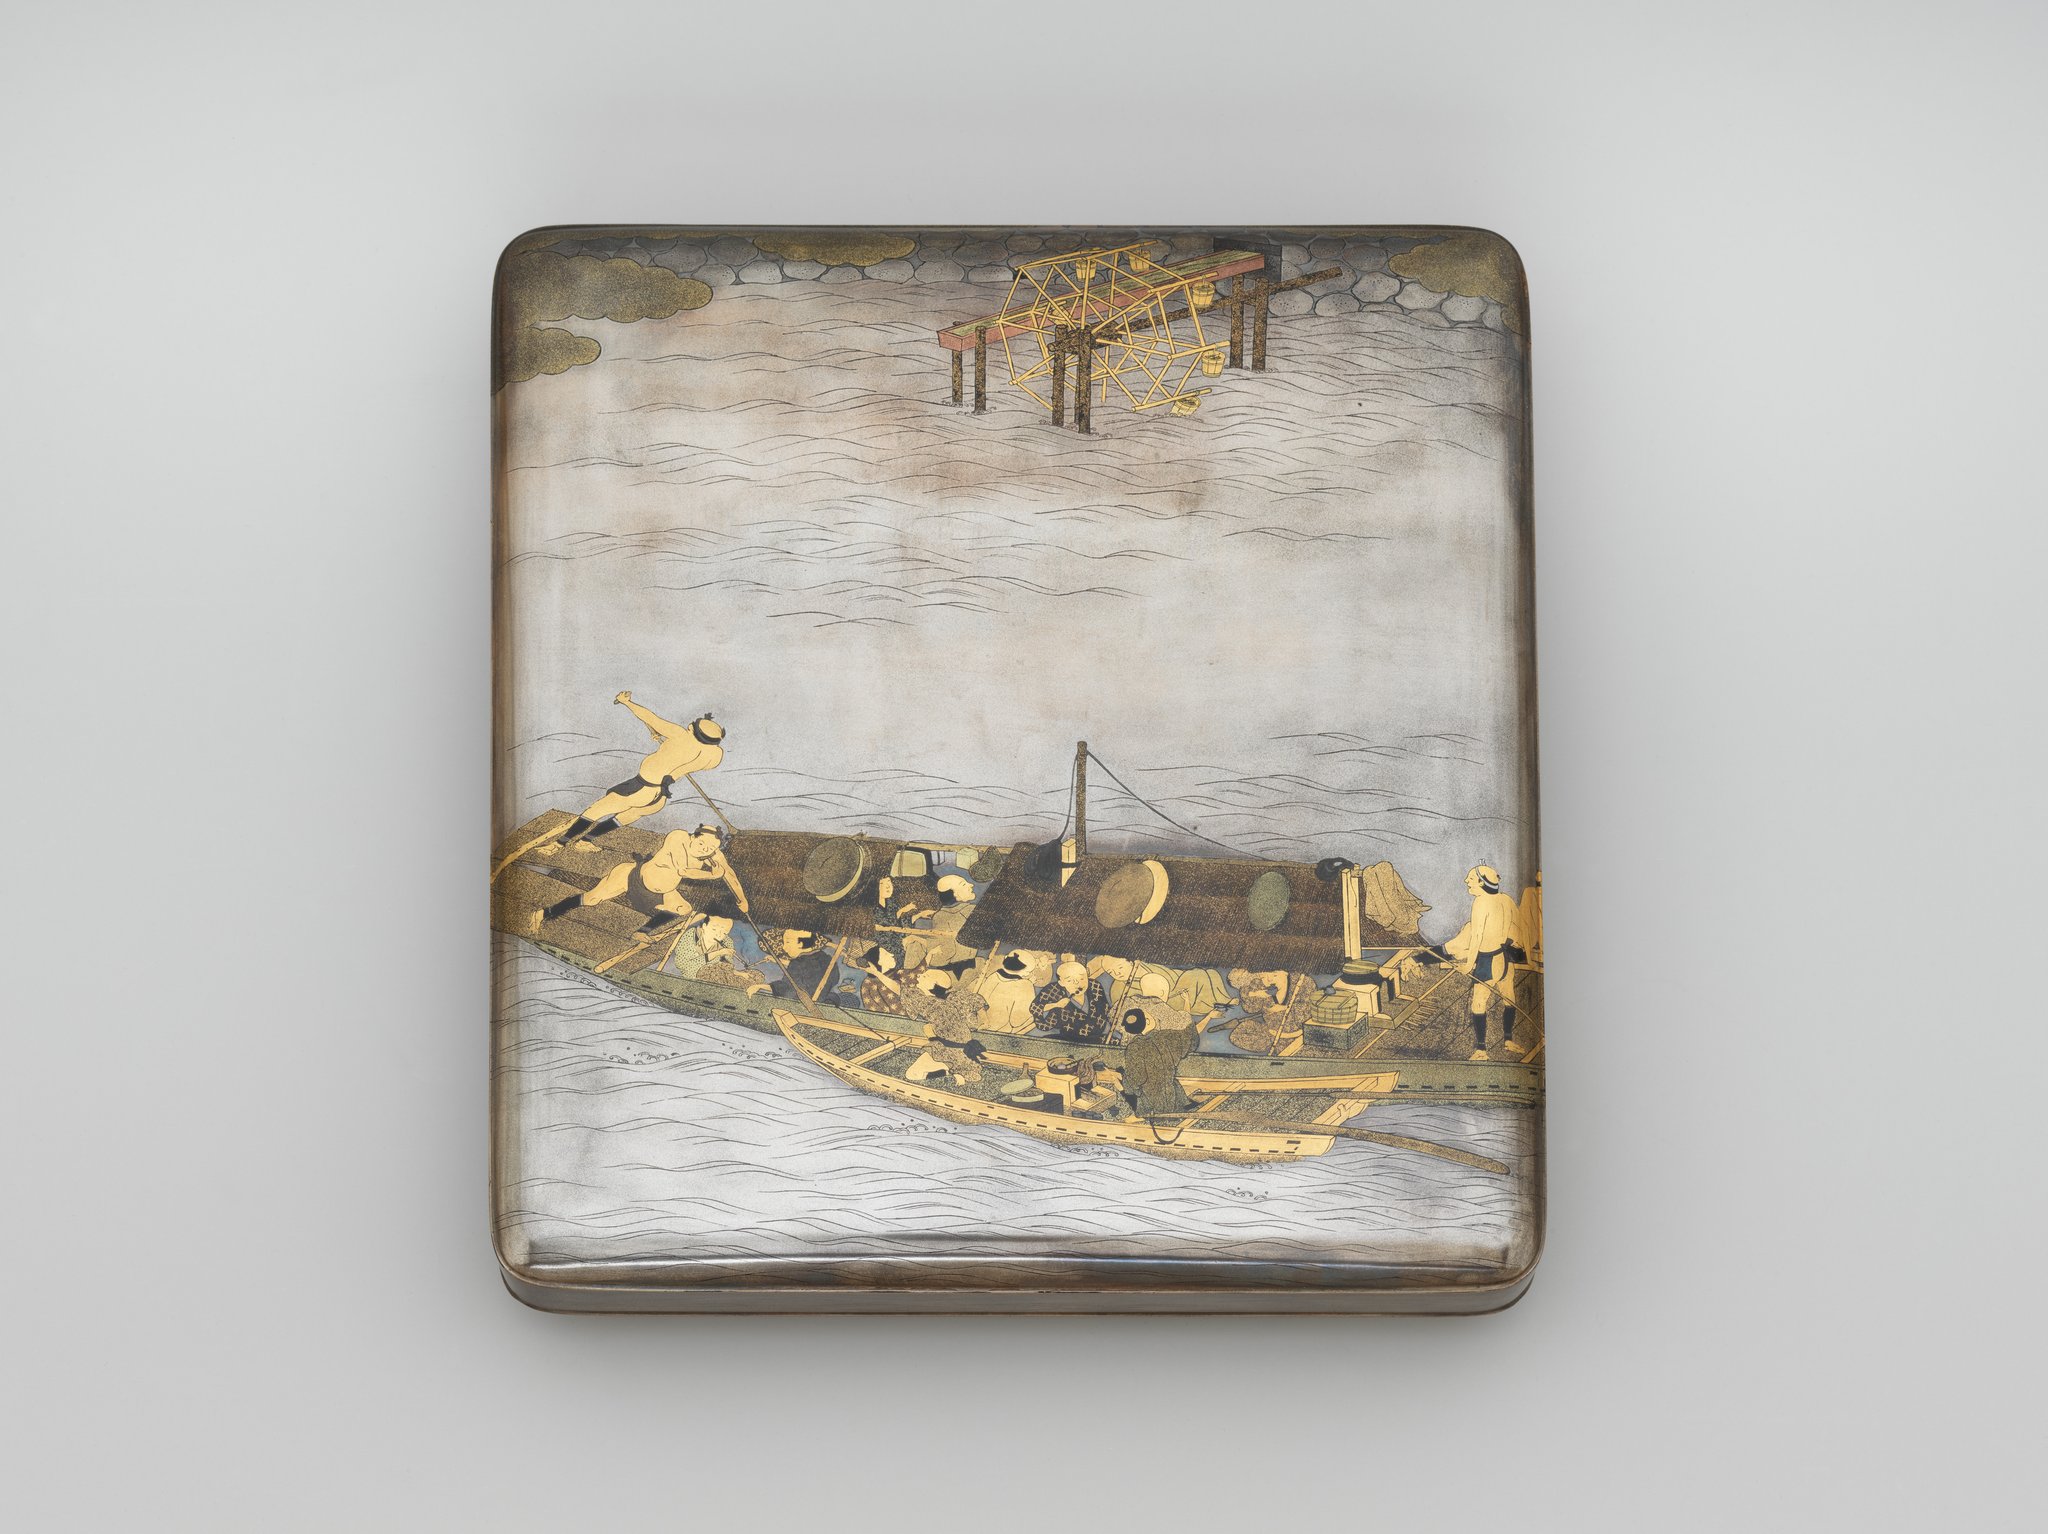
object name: writing box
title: Writing box (suzuribako) with passenger boat on the Yodo River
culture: japanese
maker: shiomi masanari 塩見政誠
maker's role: artist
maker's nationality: japanese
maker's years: 1646-1719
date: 1834-1866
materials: gold, silver, wood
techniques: lacquer